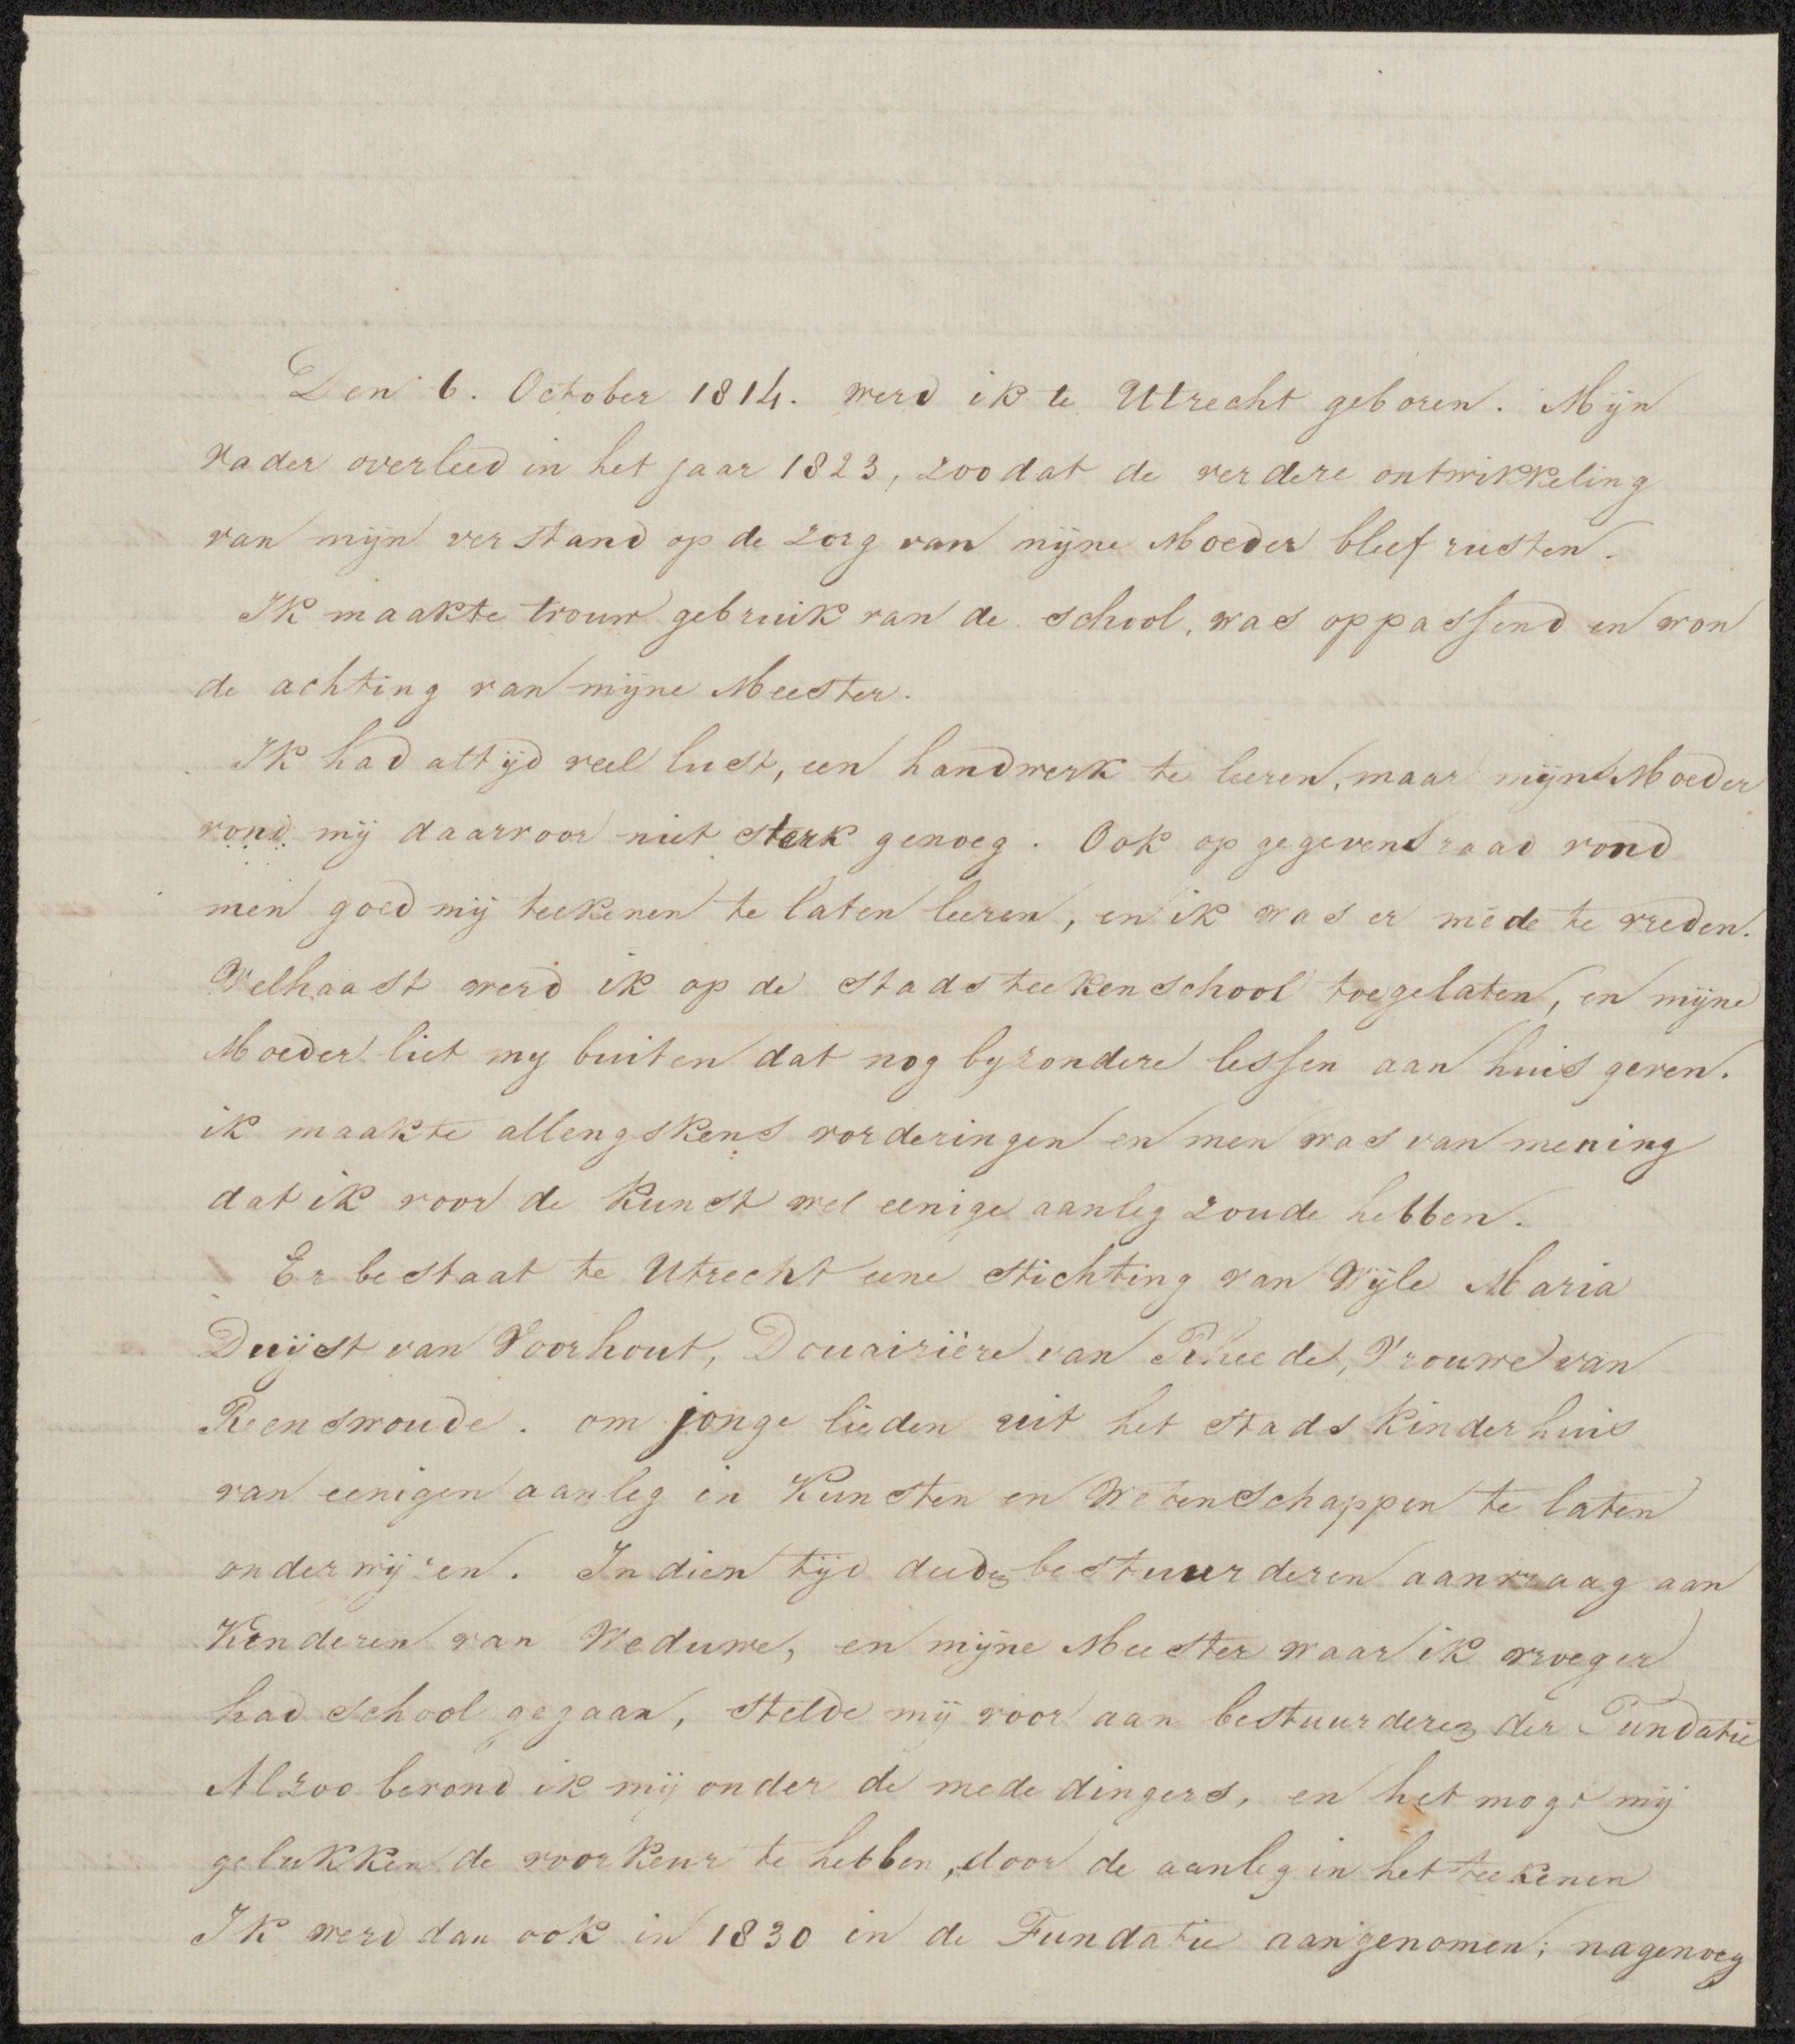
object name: manuscript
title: Handschrift betreffende Pieter Jan Guise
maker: pieter jan guise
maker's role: draughtsman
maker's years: 1814-1859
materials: ink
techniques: pen, writing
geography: roermond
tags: johannes van ravenswaay, art trade, art shop, drawing, education, tuition of the artist (in general), painting (including book-illumination, miniature-painting), exhibition ~ art, the hague, amsterdam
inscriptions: watermark